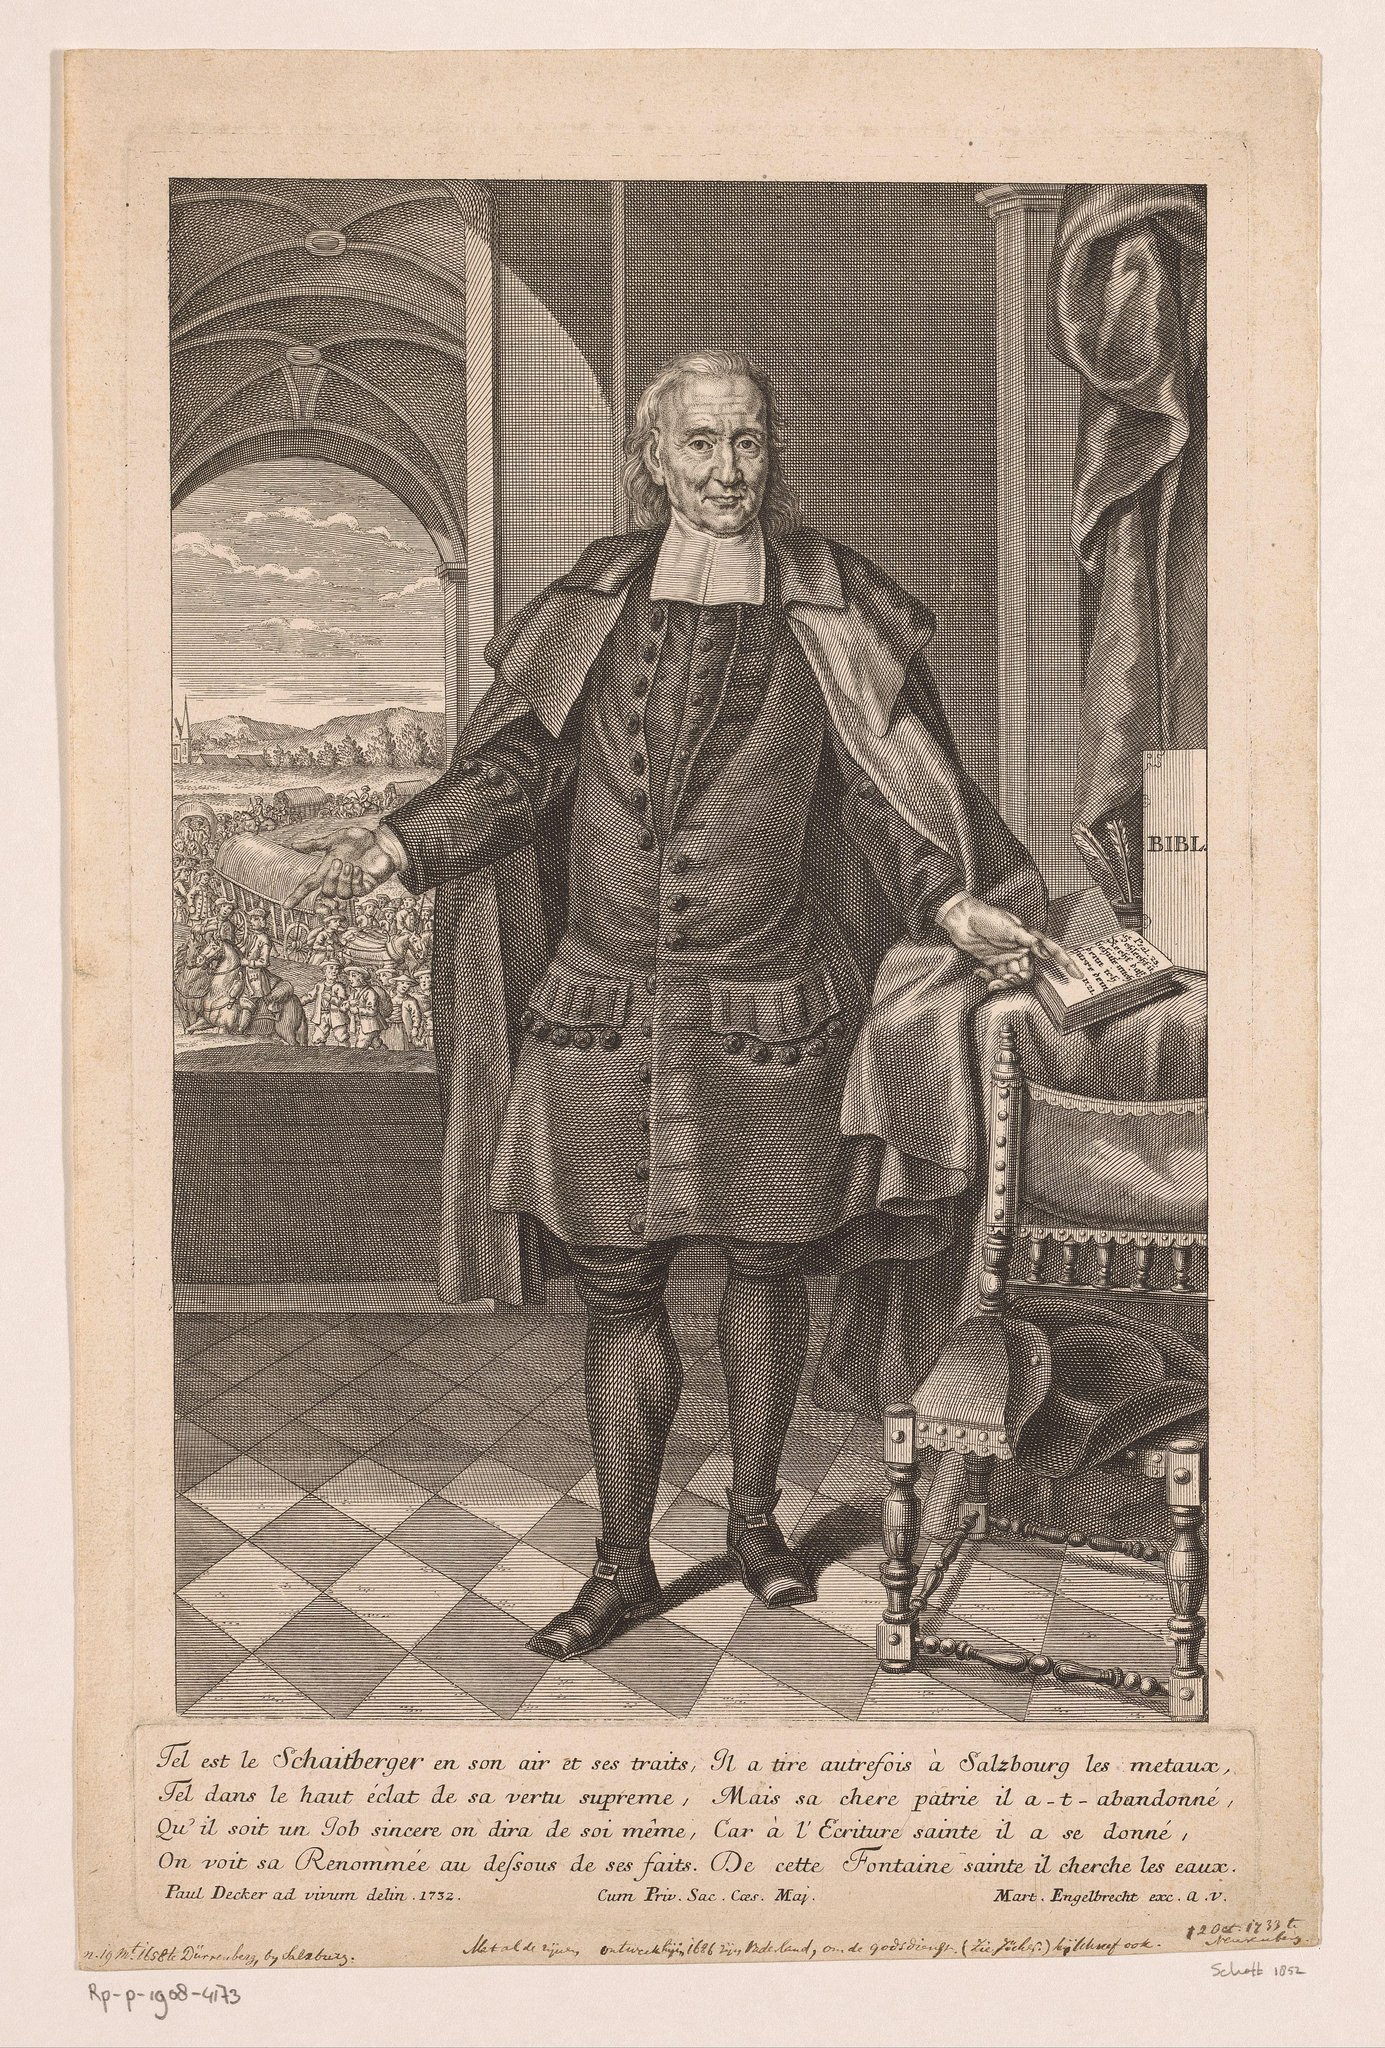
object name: print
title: Portret van Joseph Schaitberger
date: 1732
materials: paper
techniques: engraving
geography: augsburg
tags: bible, emigration, historical persons, 'en route', traveller under way, the book of psalms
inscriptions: collector's mark: Lugt 2228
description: Joseph Schaitberger wijst met zijn linkerhand naar een pagina waarop een deel uit Psalm 25 is te lezen. Met zijn rechterhand wijst hij naar een groep reizigers, welke vanuit het raam te zien zijn. Met onderschrift in het Frans.